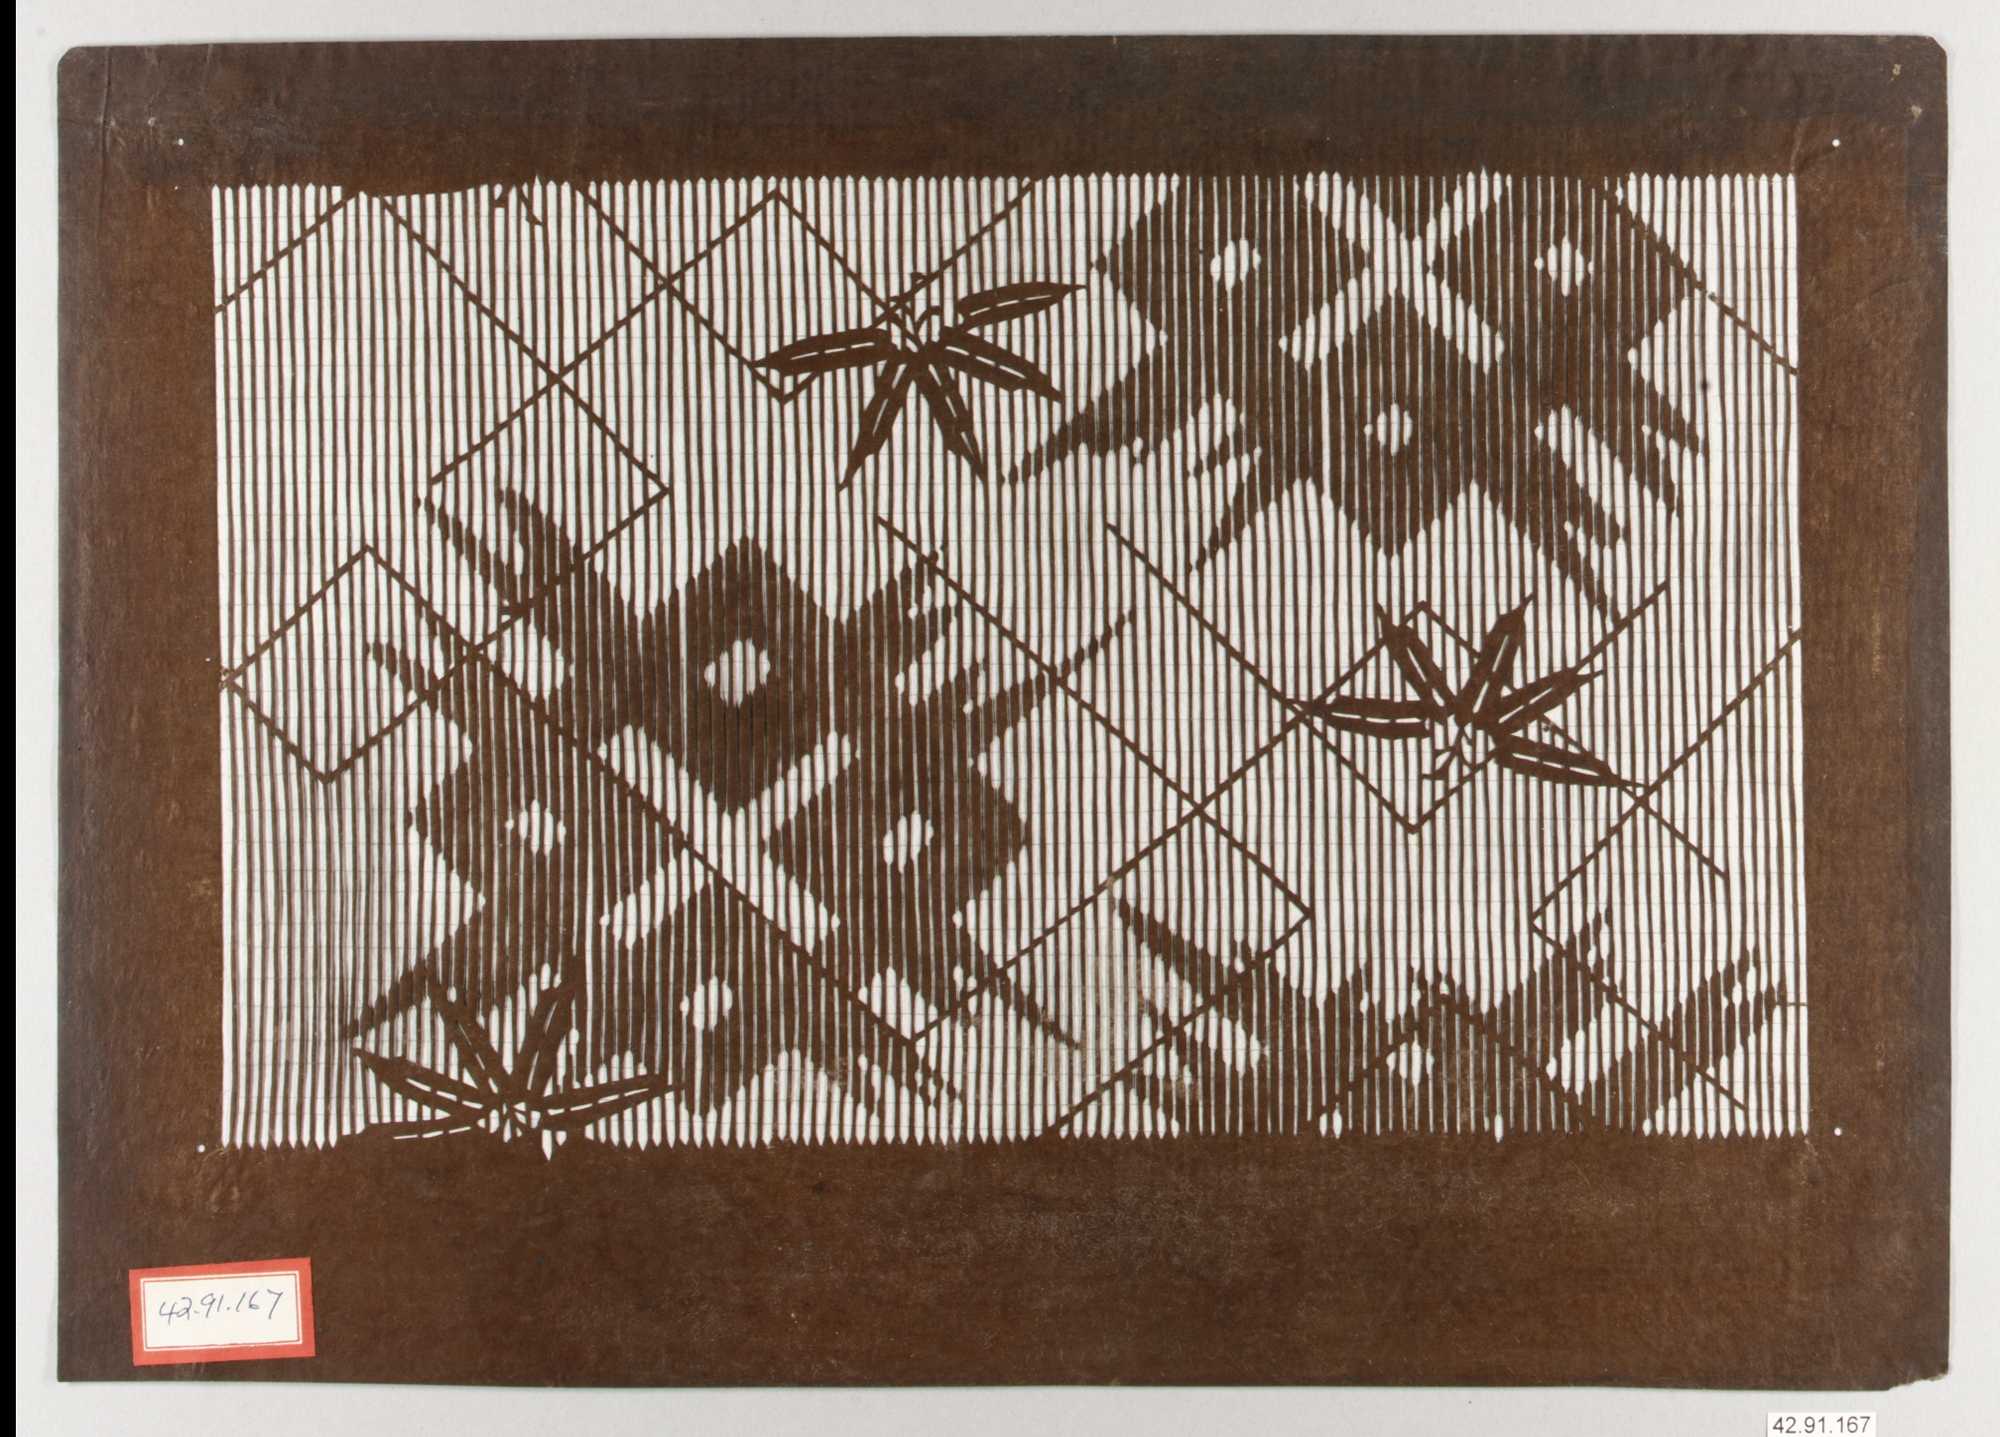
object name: stencil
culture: japanese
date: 1801-1900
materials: paper, silk